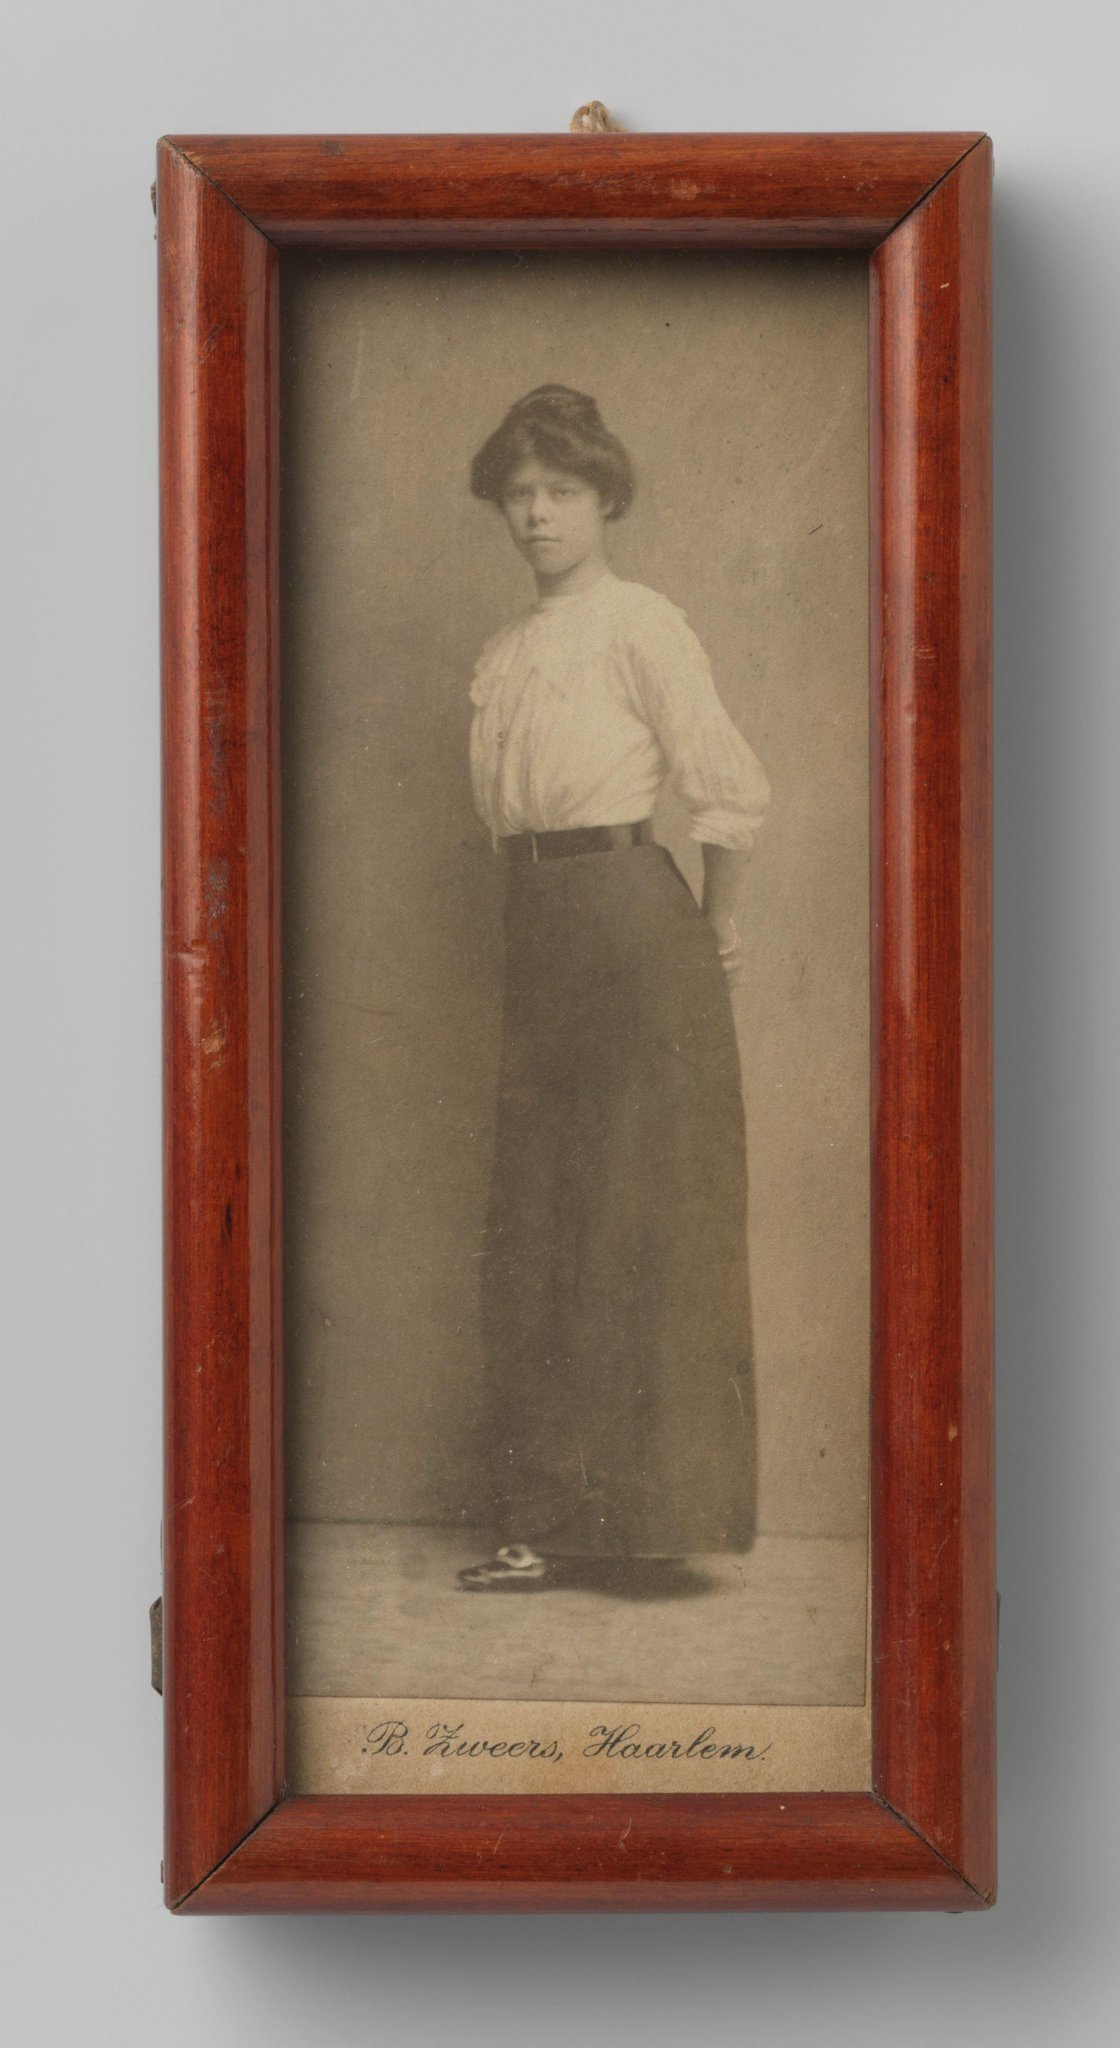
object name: frame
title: Portret van een onbekende vrouw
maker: berend zweers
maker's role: fotograaf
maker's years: 1872-1946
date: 1880-1920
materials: paper, cardboard, glass, metal, wood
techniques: gelatin silver print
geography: haarlem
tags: anonymous historical person portrayed - bb - woman